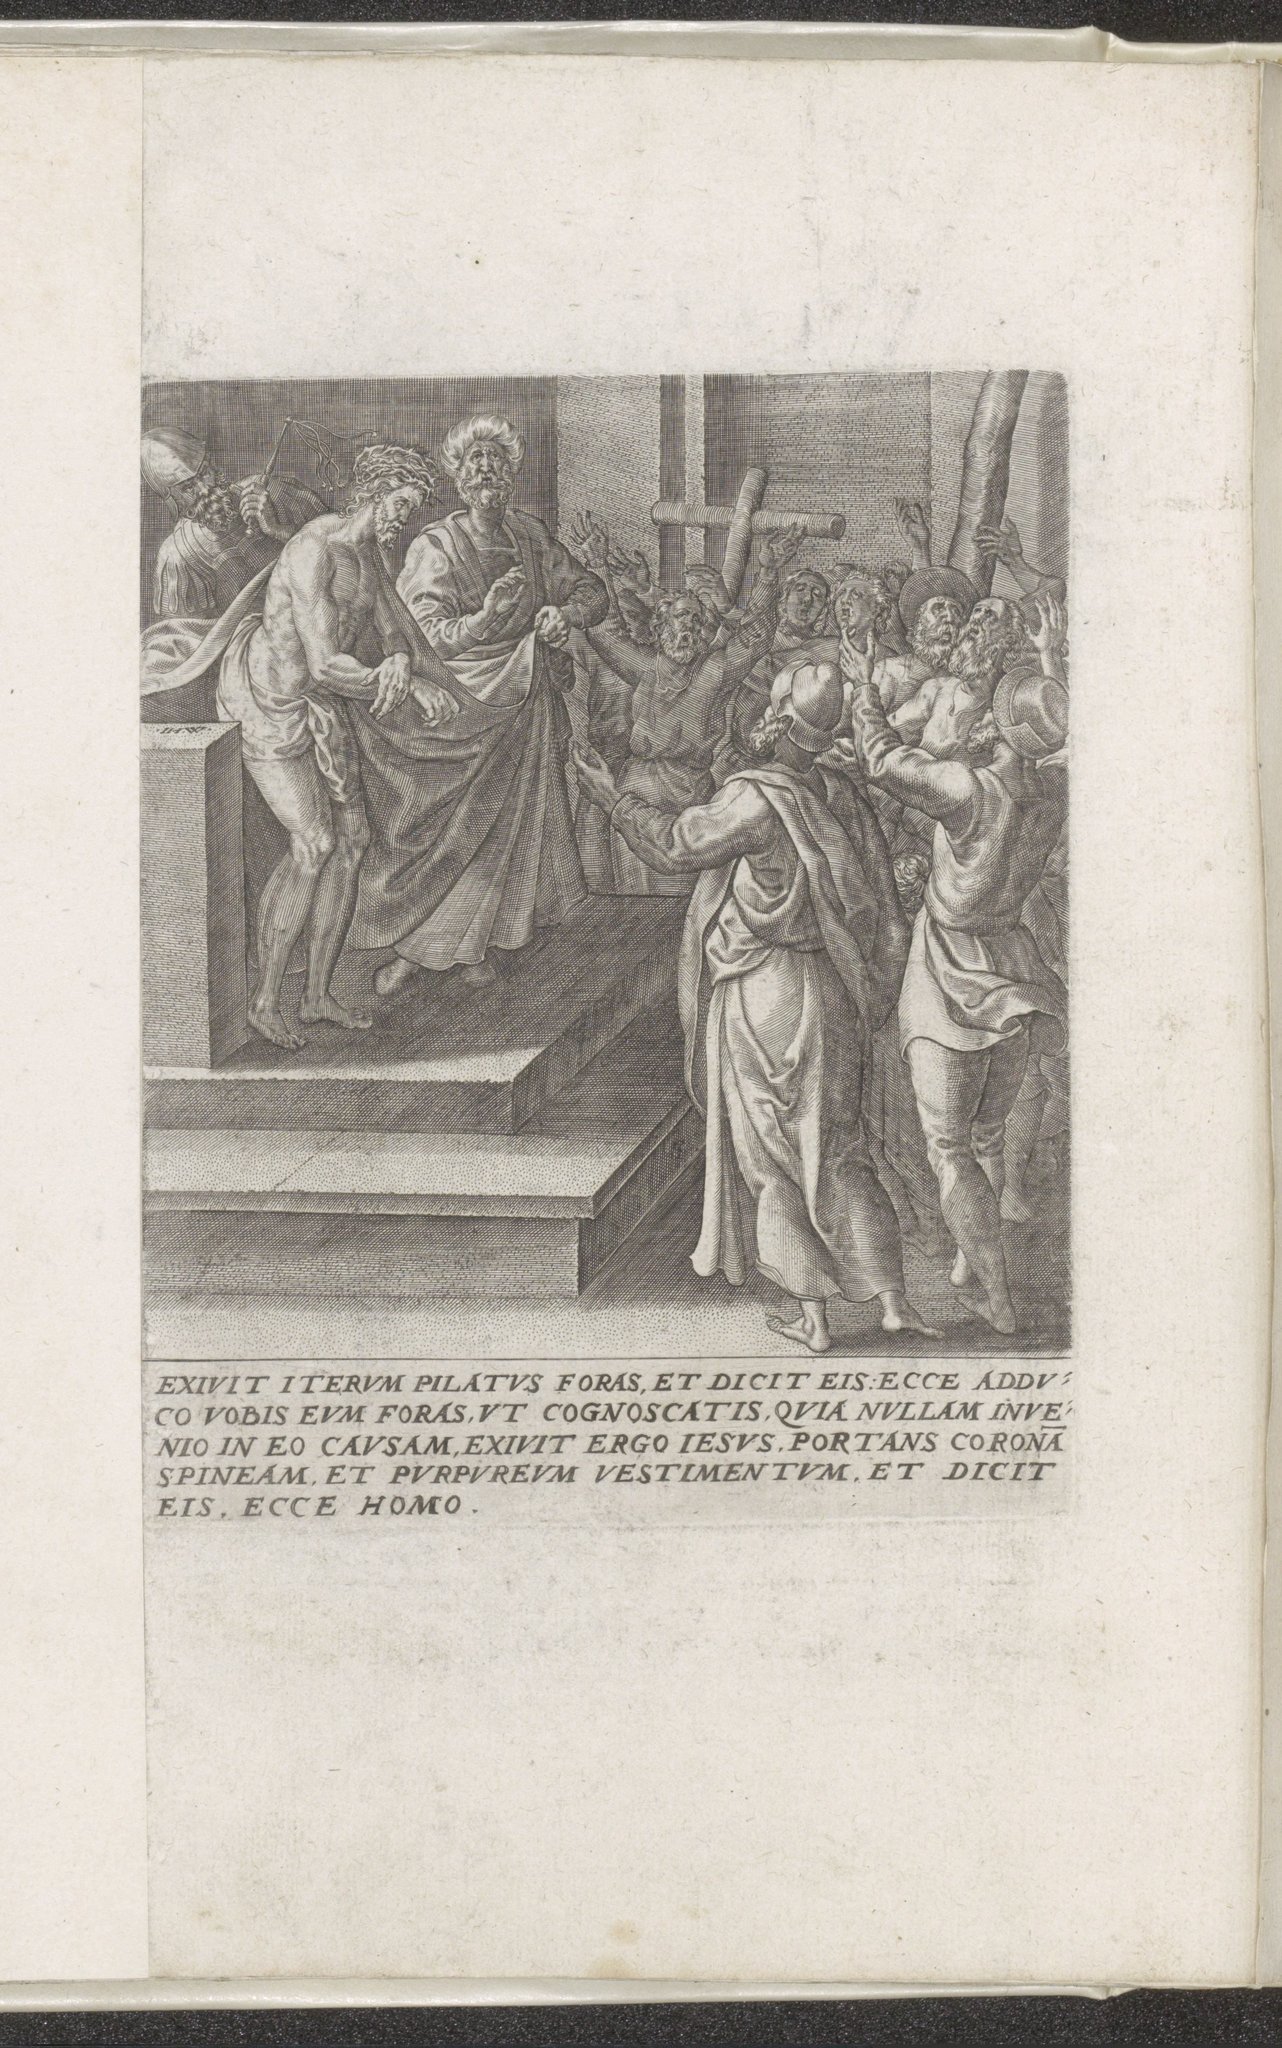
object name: album leaf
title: Mnimata Dominicae Passionis Historiam Necisque Nostrae Mortem Complexa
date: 1572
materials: paper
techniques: engraving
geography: antwerp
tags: pilate showing christ to the people, 'ostentatio christi', 'ecce homo' (john 19:4-6)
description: Tijdens de restauratie in 1988 bleek dat op de achterzijde van de prenten van de Passie-serie van Wierix Latijnse teksten in boekdruk staan. Deze vormen, wanneer op de juiste wijze in boekvorm gebonden (wat nu in het Heemskerck-album niet het geval is), een toelichting op de passievoorstellingen. Om de teksten zichtbaar te laten zijn de prenten bij de restauratie niet meer met de achterzijde op elkaar geplakt.